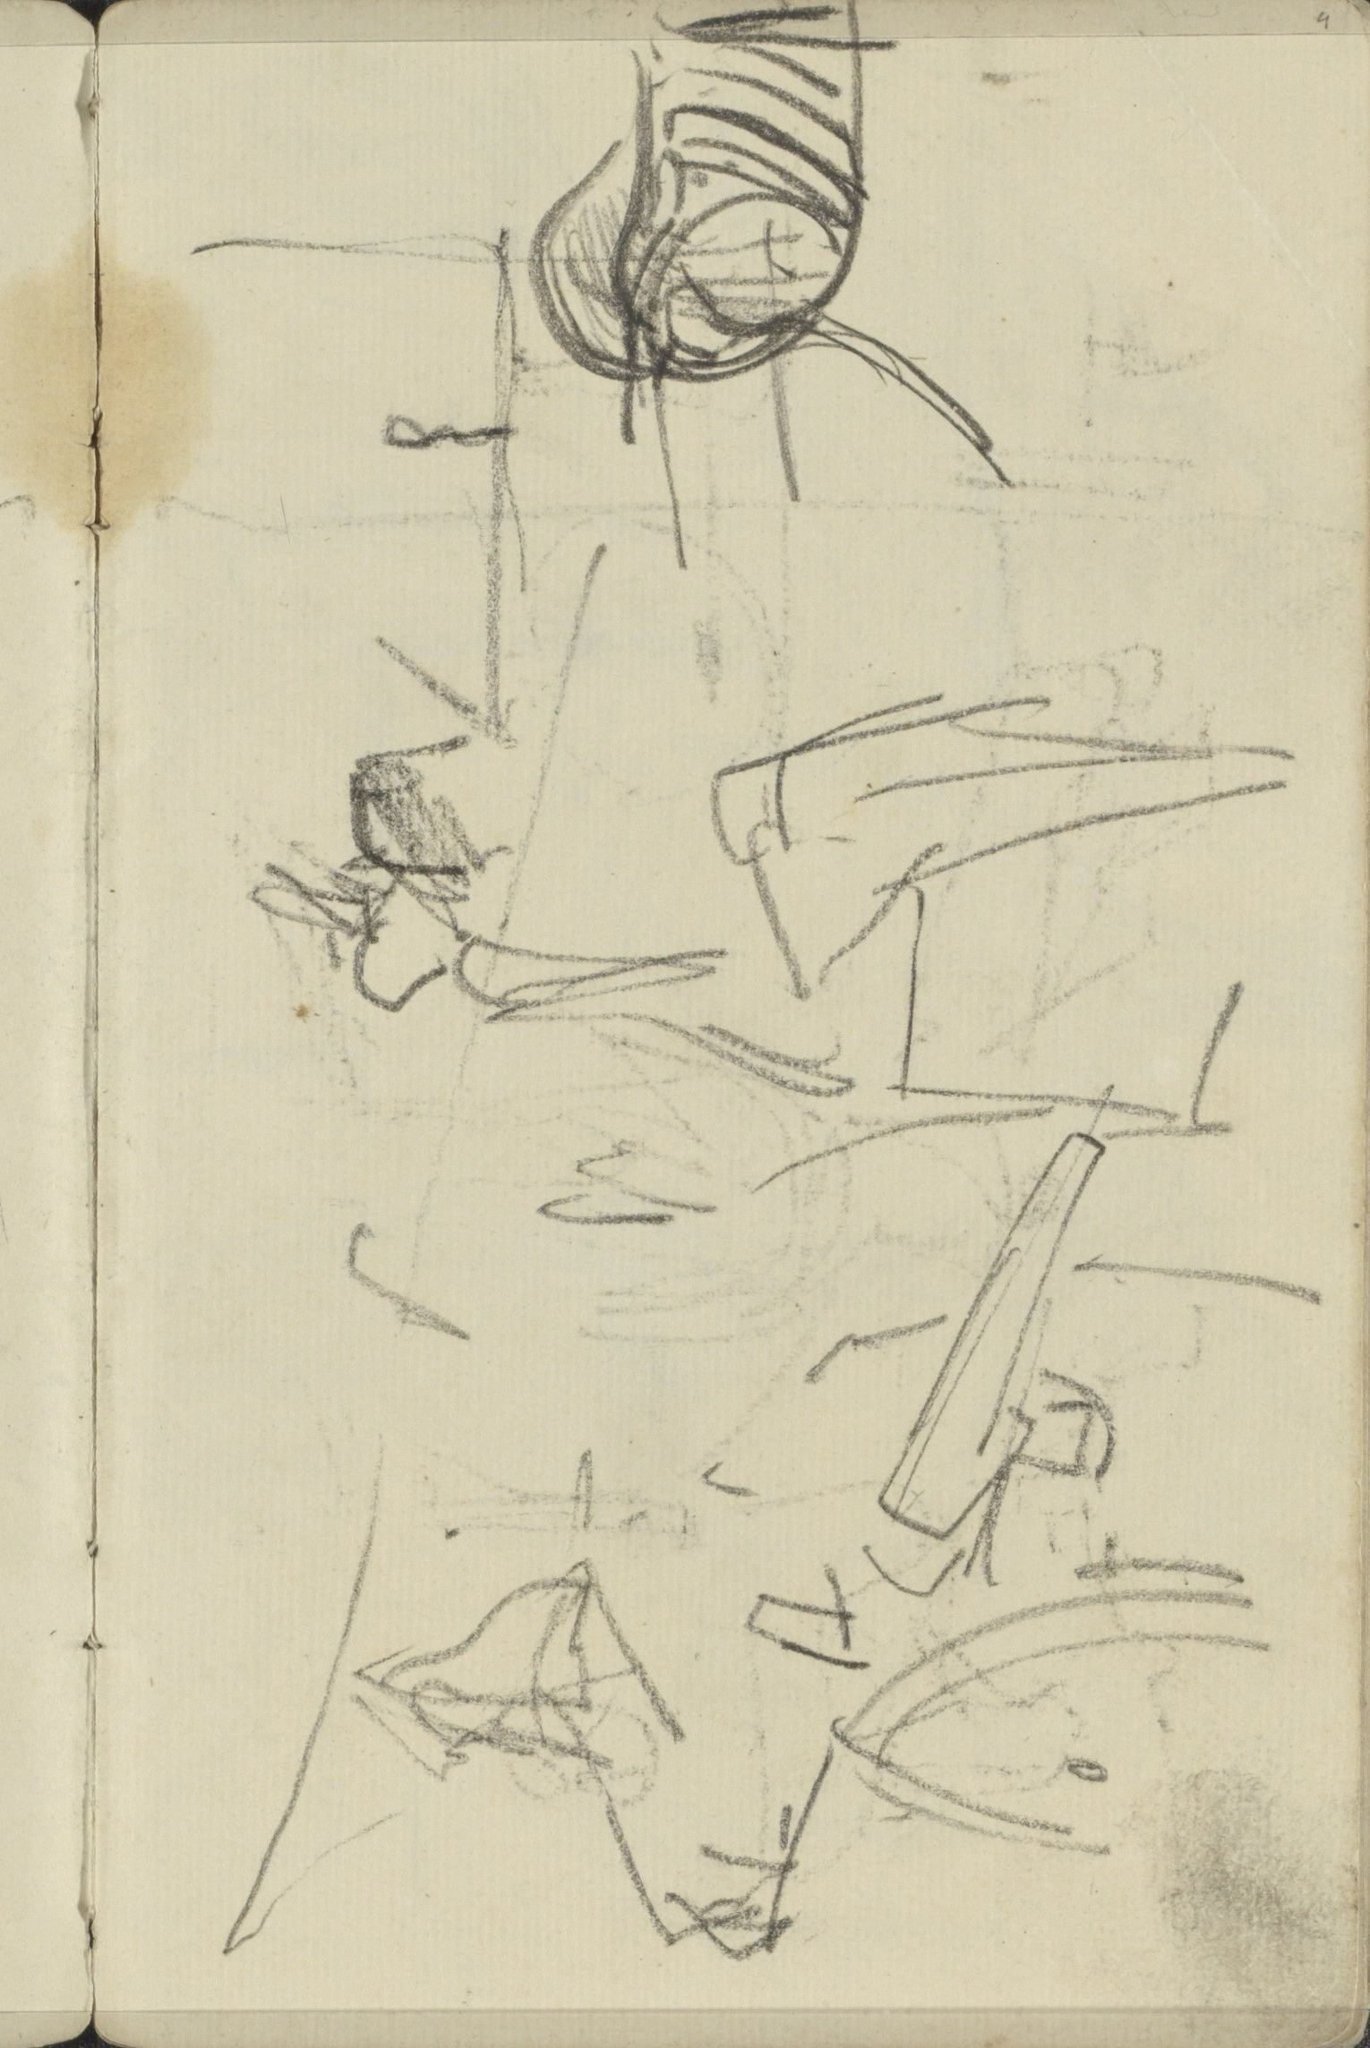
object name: sketchbook leaf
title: Ruiter en een kar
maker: george hendrik breitner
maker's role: draughtsman, painter, print maker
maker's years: 1857-1923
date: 1880-1882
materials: chalk, paper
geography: the hague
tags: riding a horse, ass, or mule; rider, horseman, (farm) wagon, freight wagon, cart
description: Pagina 4 uit een schetsboek met 19 bladen.